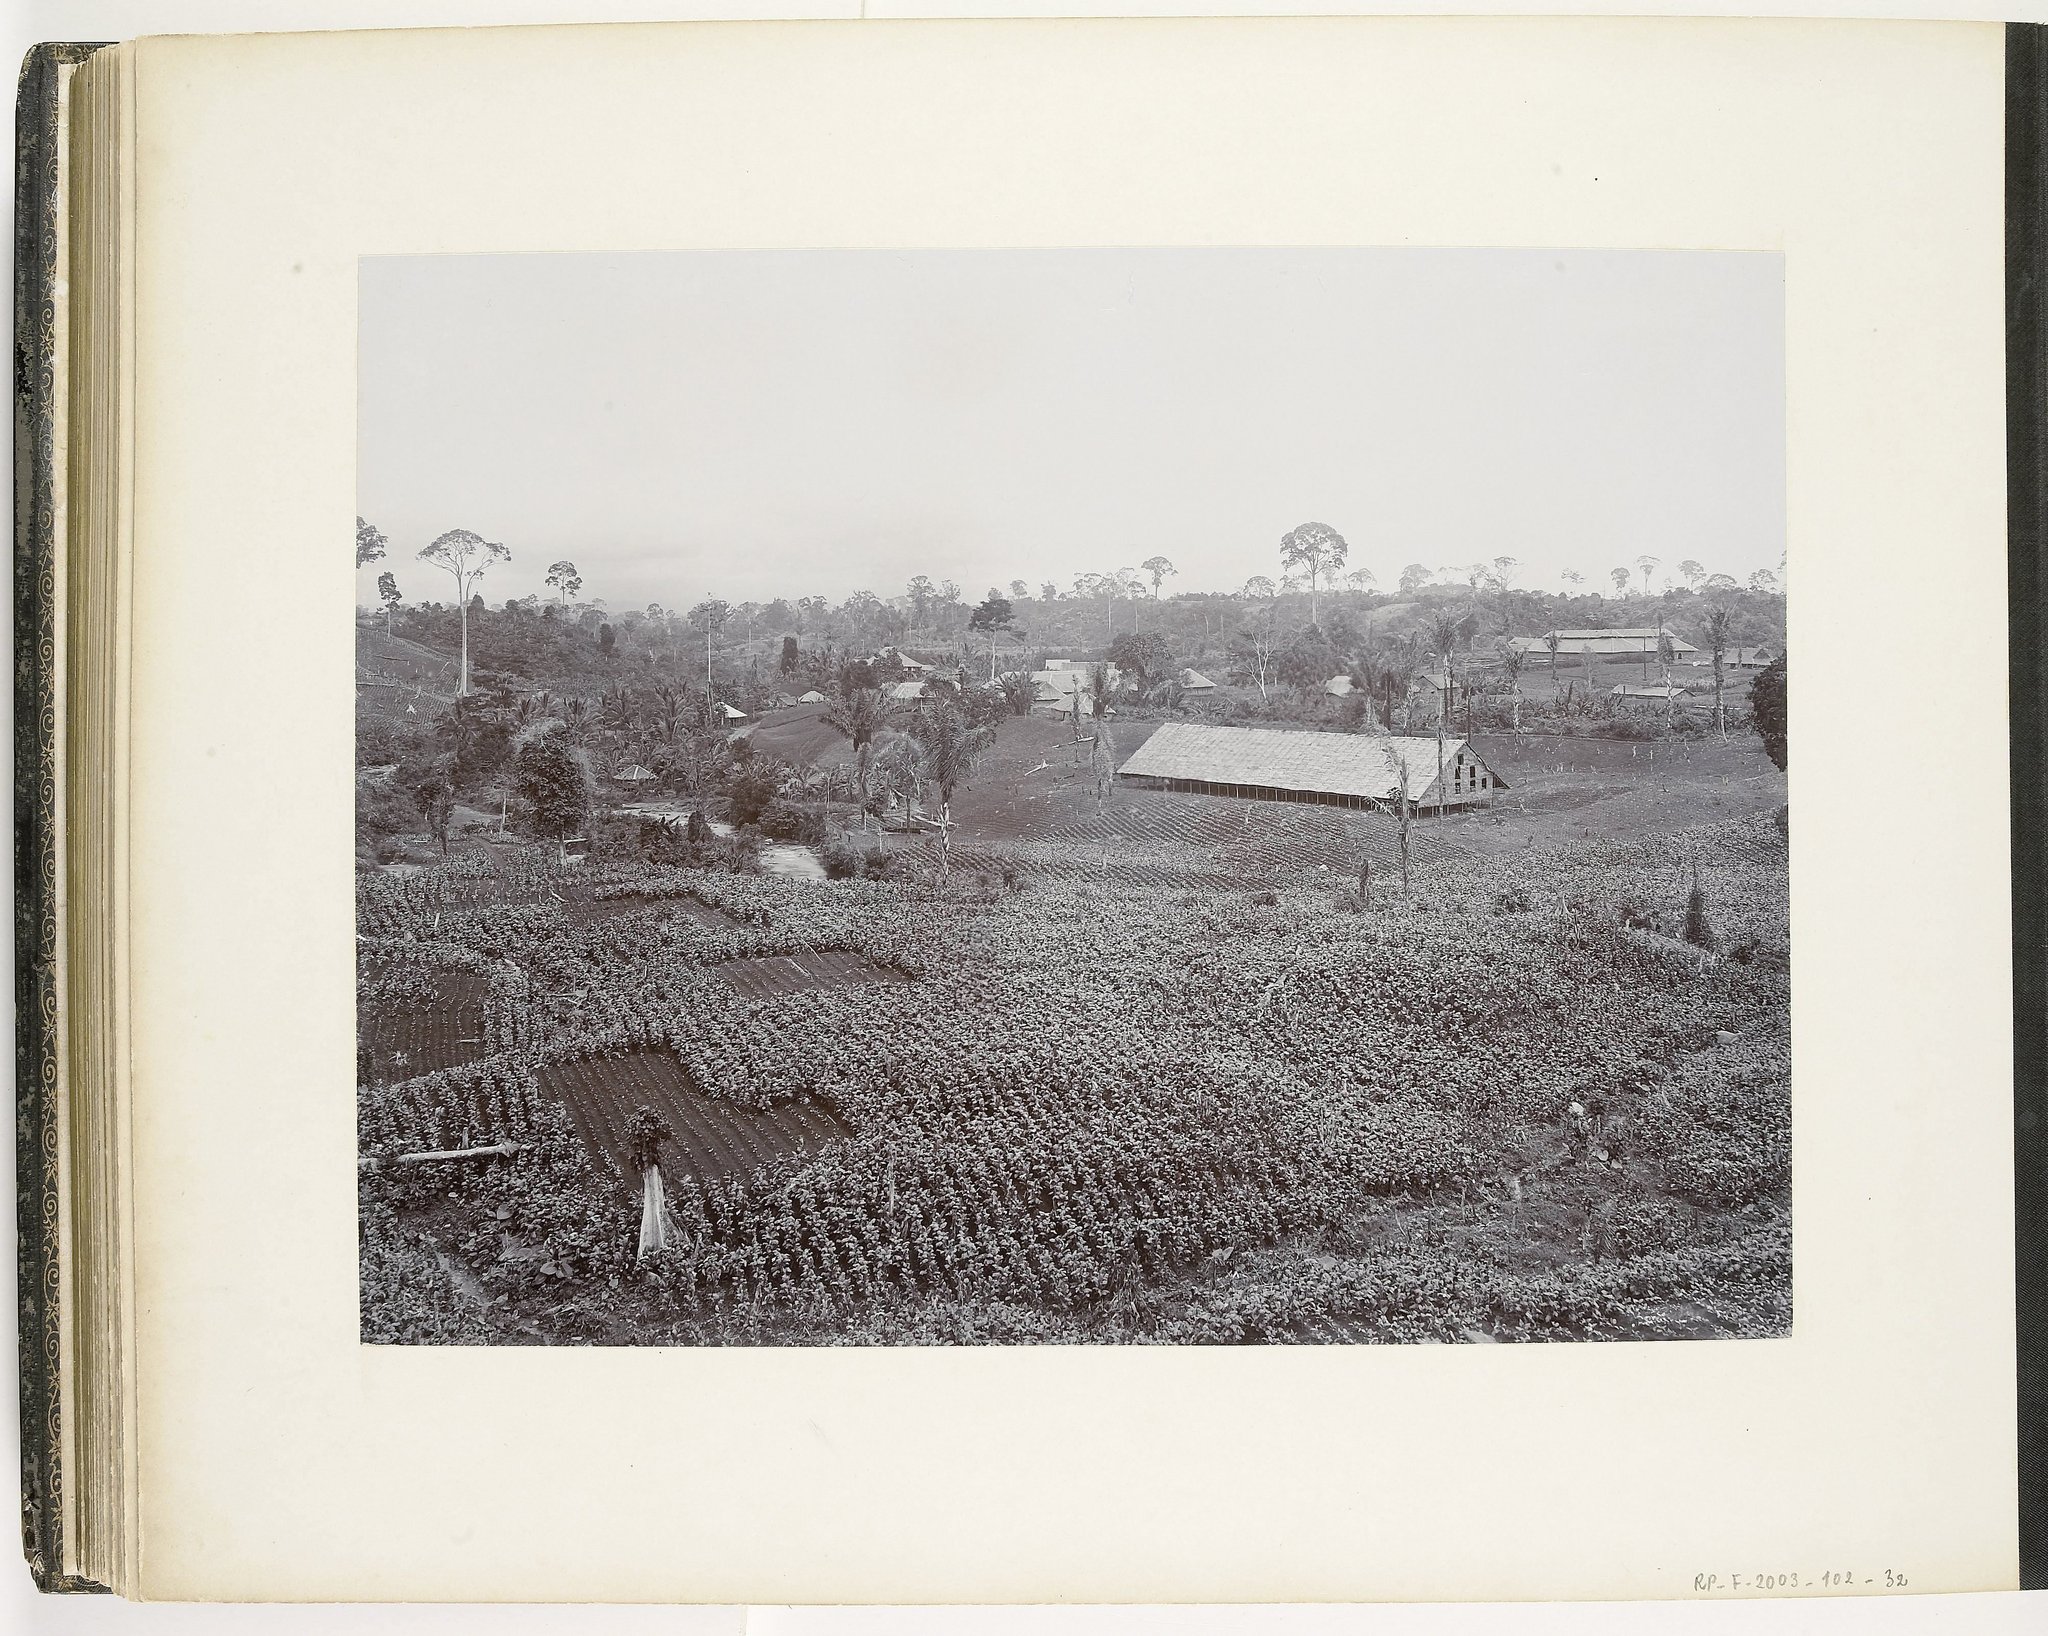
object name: photograph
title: View of the Gambir Estate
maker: carl j. kleingrothe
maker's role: fotograaf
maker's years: 1864-1925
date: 1885-1900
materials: photographic support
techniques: collodion silver print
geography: deli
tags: sumatra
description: Gezicht op de tabaksvelden op de plantage Gambir Estate in Deli op Sumatra. Onderdeel van het Sumatra fotoalbum van Paul en Lucie Sandel uit 1900.